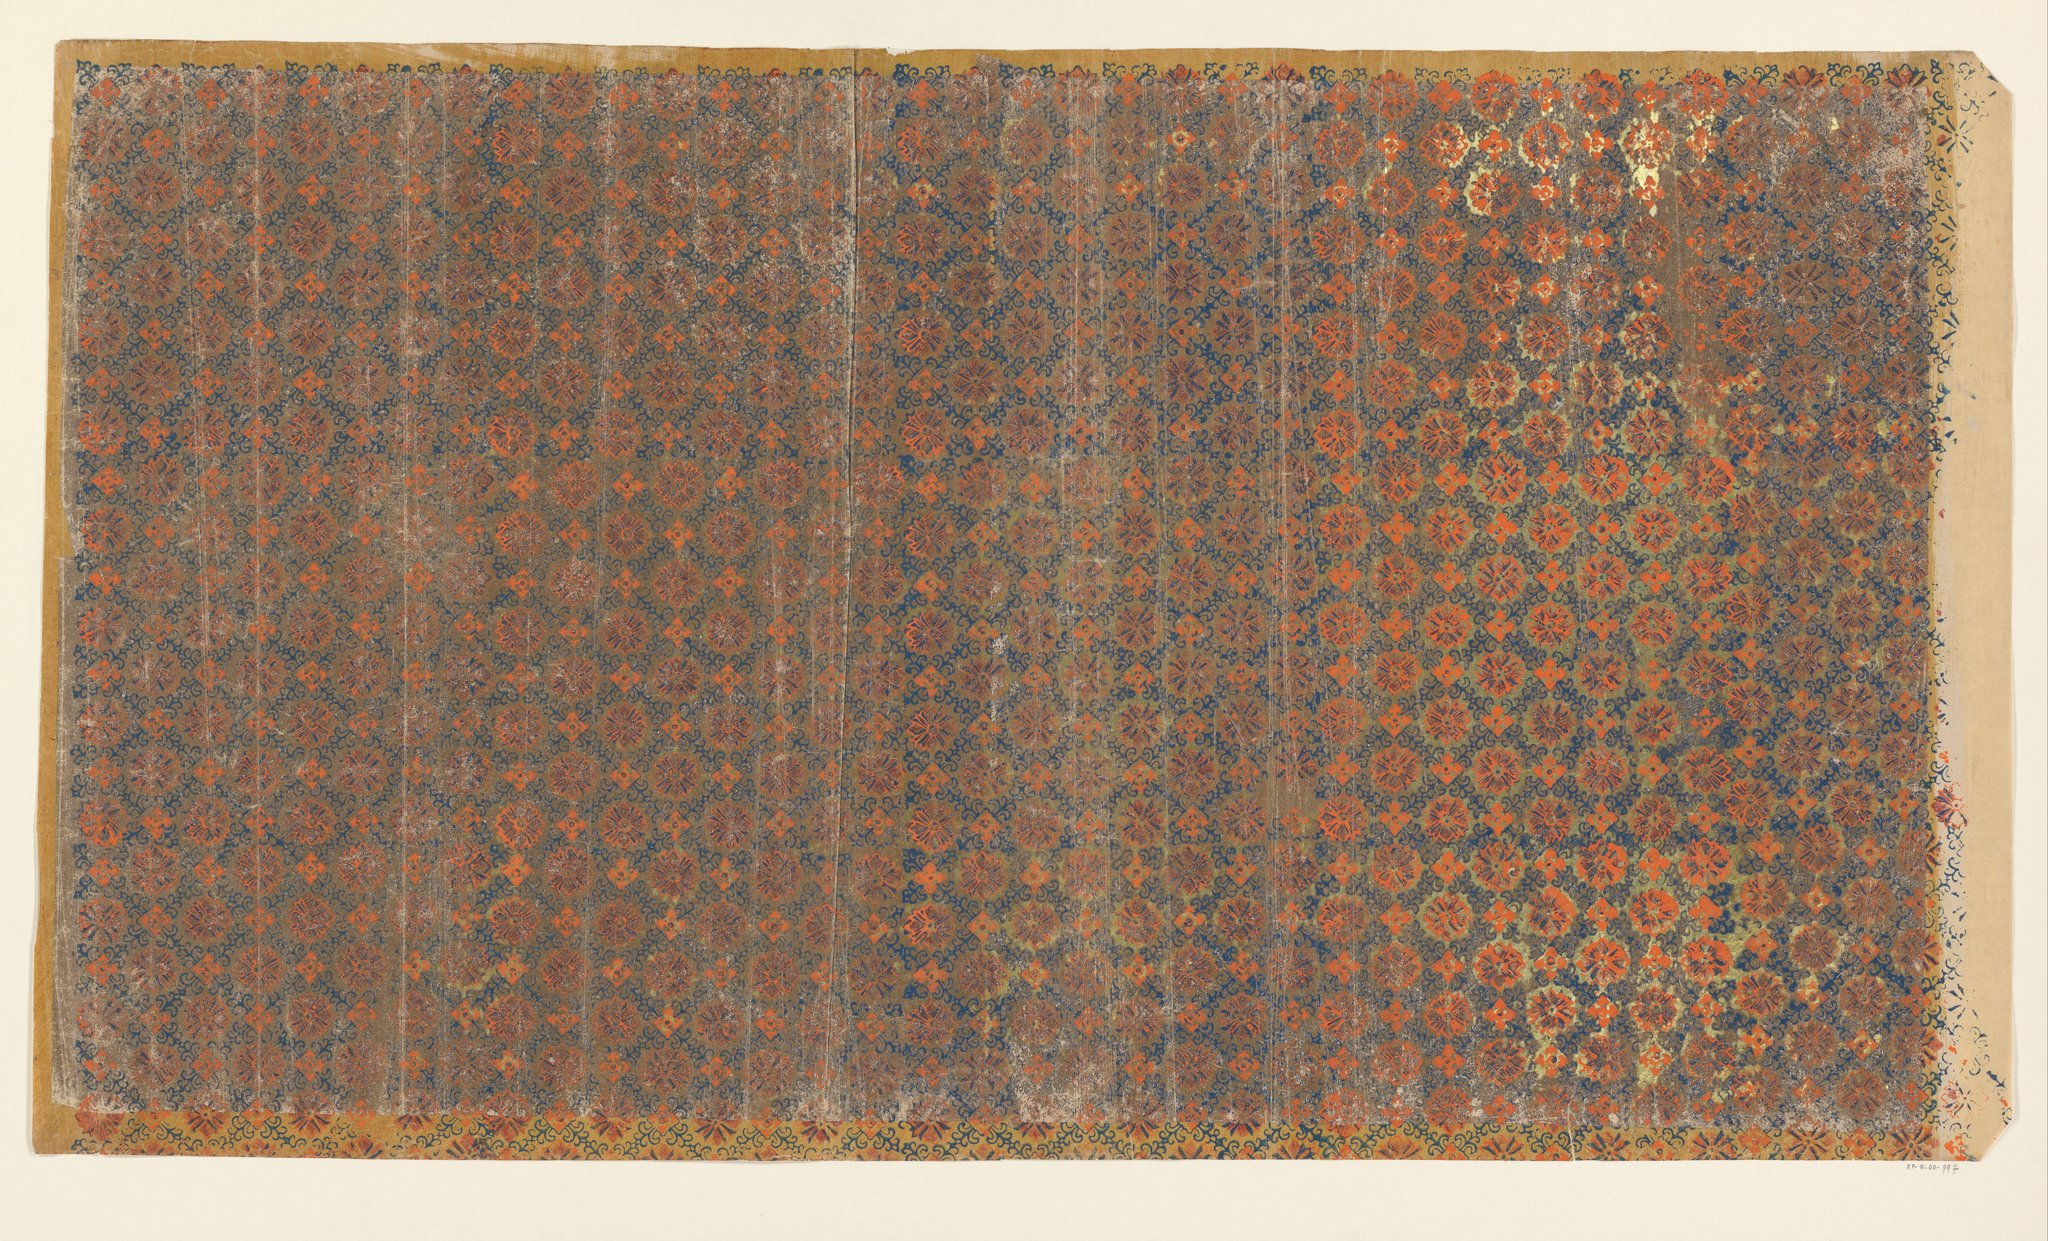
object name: decorated paper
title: Blad met ruitenpatroon van ranken met bloem als veldvulling (één van acht identieke bladen)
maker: Anonymous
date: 1850-1950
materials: paper, gold leaf, paint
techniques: printing block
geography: japan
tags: ornament derived from plant forms